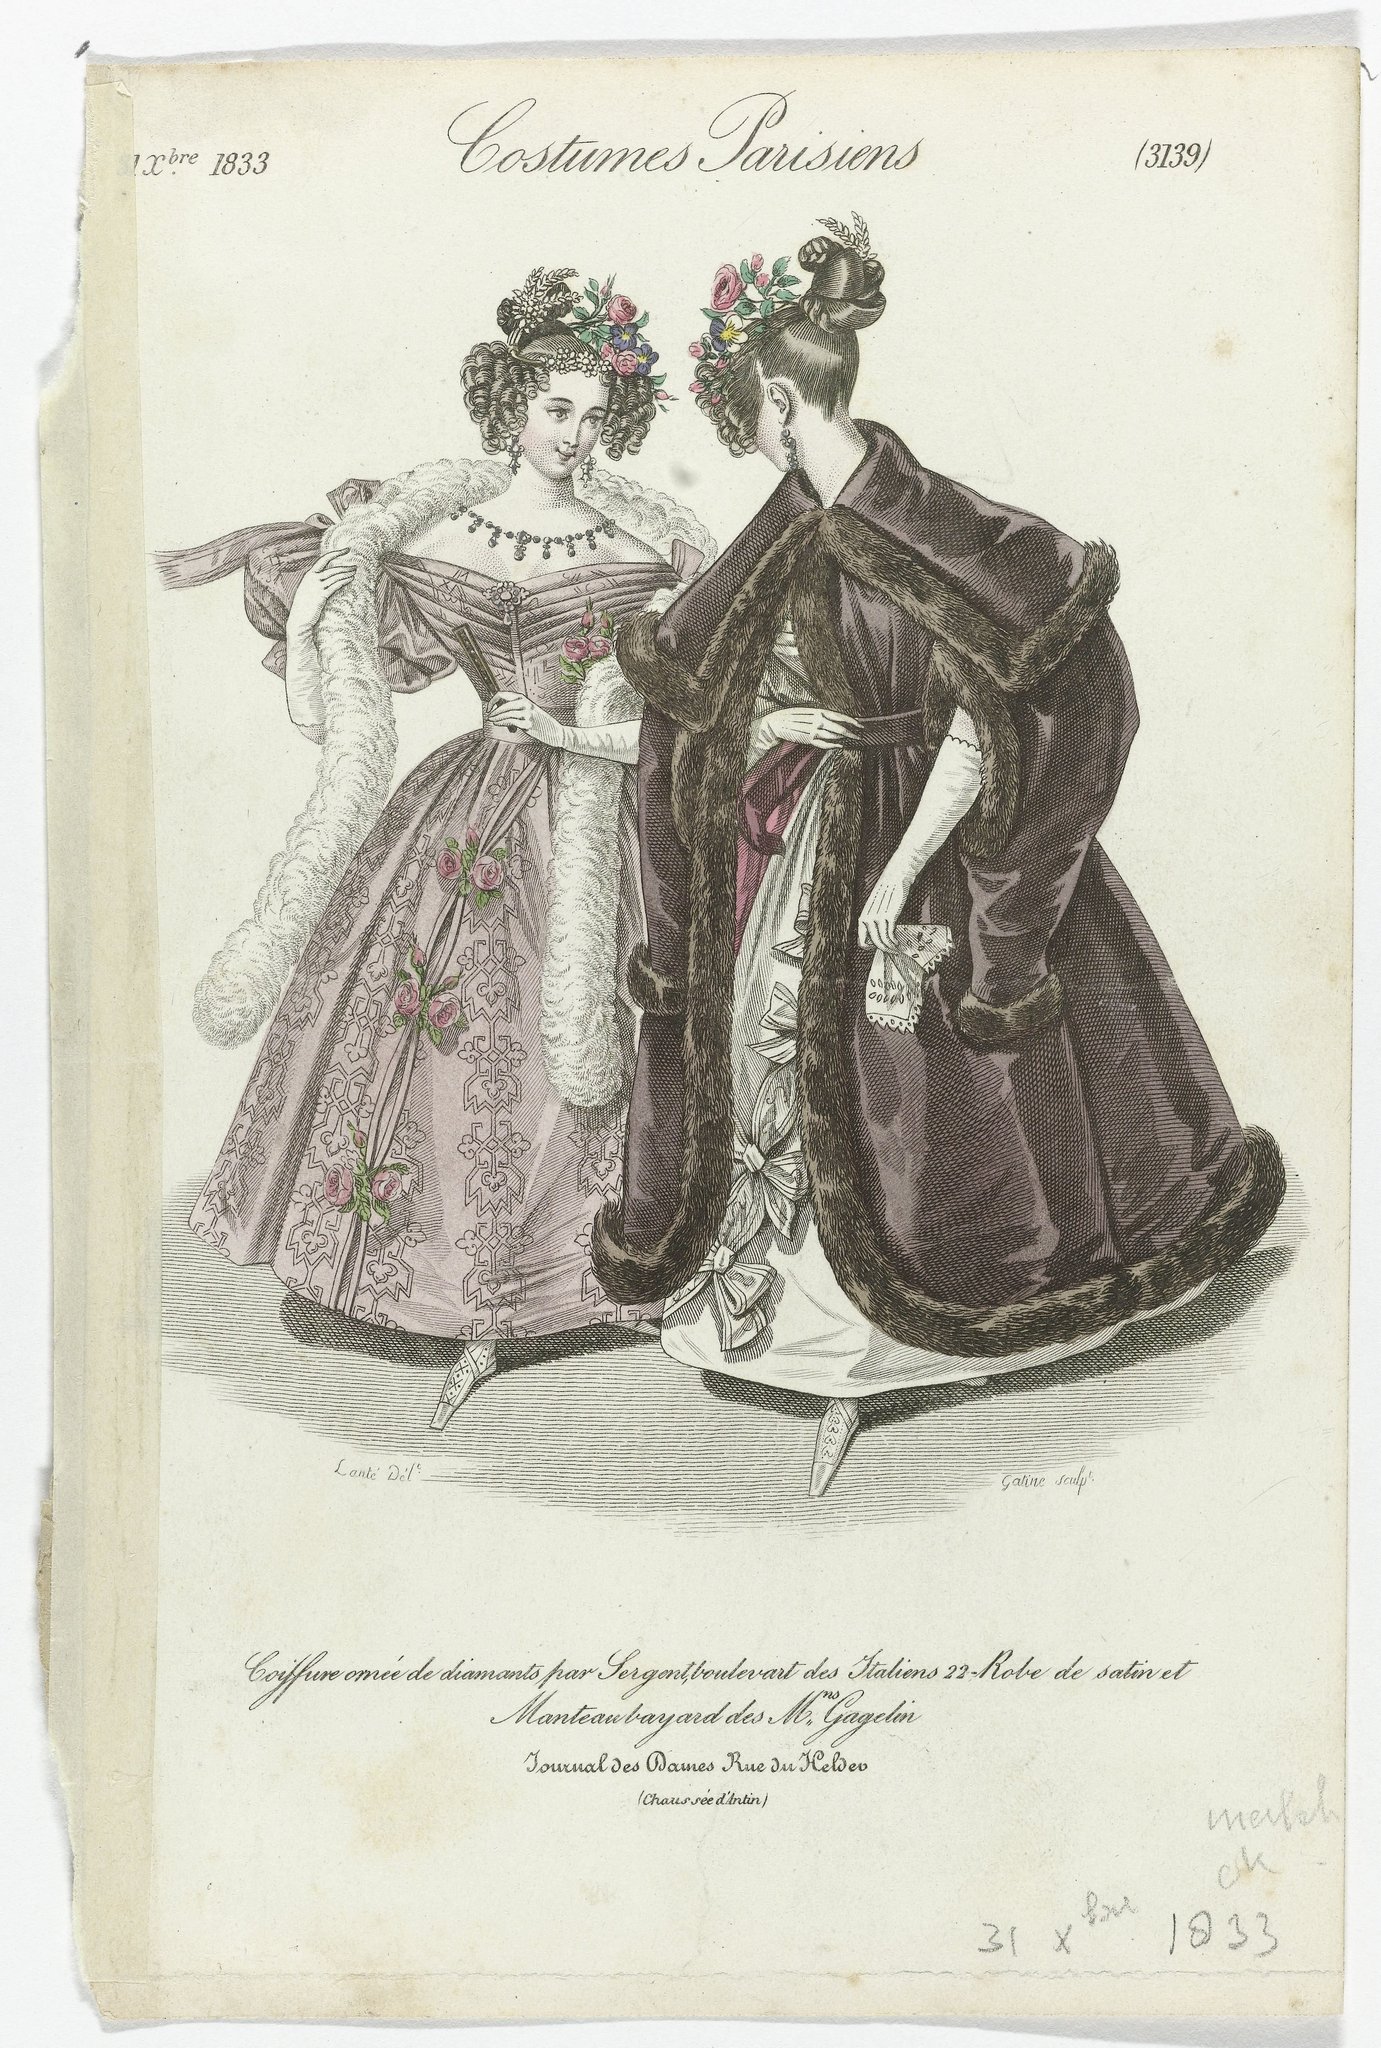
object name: fashion print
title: Journal des Dames et des Modes, Costumes Parisiens, 31 décembre 1833, (3139) : Coiffure ornée de diamants (...)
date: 1833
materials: paper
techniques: engraving, hand coloring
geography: paris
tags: corsage (+ women's clothes), flowers, ear-rings (+ women's clothes), brooch, agraffe, clasp (+ women's clothes), dress, gown: evening dress (+ women's clothes), ornamental parts of clothing (+ fur used for clothes), coat (+ women's clothes), styles of hairdress - aa - ~ women, fashion plates, clothing for the upper part of the body (shawl) (+ fur used for clothes), sleeves (+ women's clothes), necklace (+ women's clothes)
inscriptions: address: ‘Journal des Dames Rue du Helder / (Chaussée d'Antin)’, title: ‘Costumes Parisiens’, caption: ‘Coiffure ornée de diamants par Sergent, boulevart des Italiens 22 - Robe de satin et Manteau bayard des M.ns Gagelin’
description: 'Coiffure' versierd met diamanten van Sergent. Avondjapon van satijn en 'manteau bayard' of mantel afgezet met bont uit de winkels van Gagelin. Accessoires: oorbellen, collier, broche, stola, bloemcorsage, waaier, lange handschoenen, zakdoek. Prent uit het modetijdschrift Journal des Dames et des Modes (1797-1839).